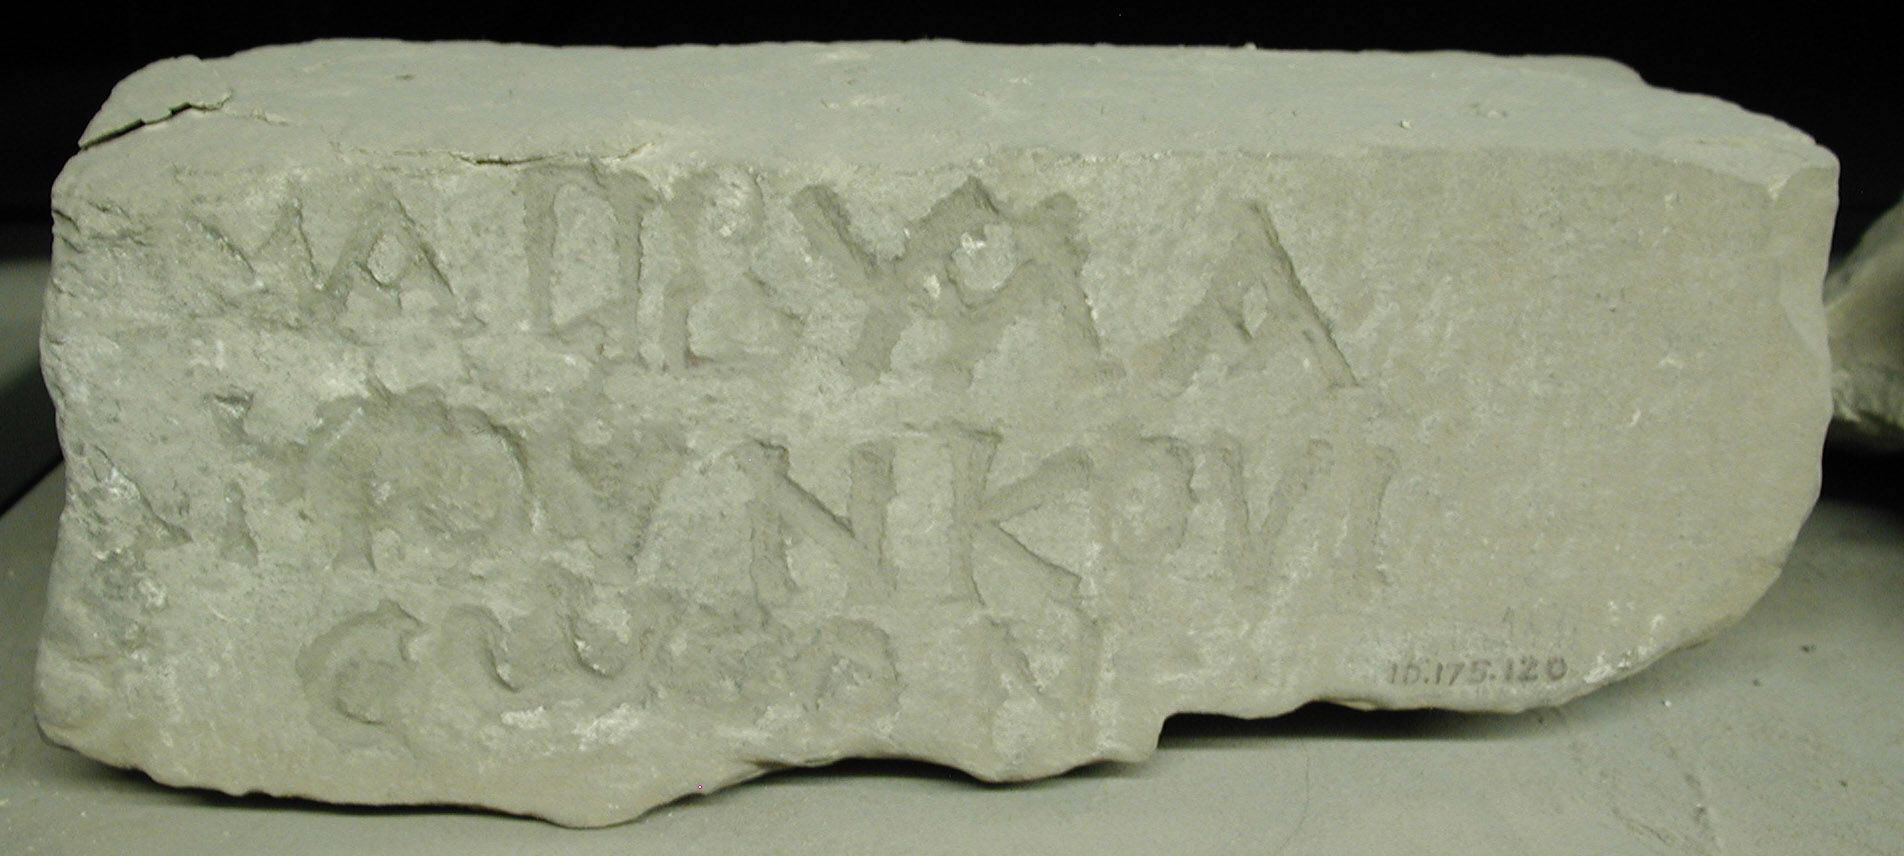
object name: fragment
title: Fragment of an Inscribed Block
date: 501-700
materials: limestone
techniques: incising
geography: egypt